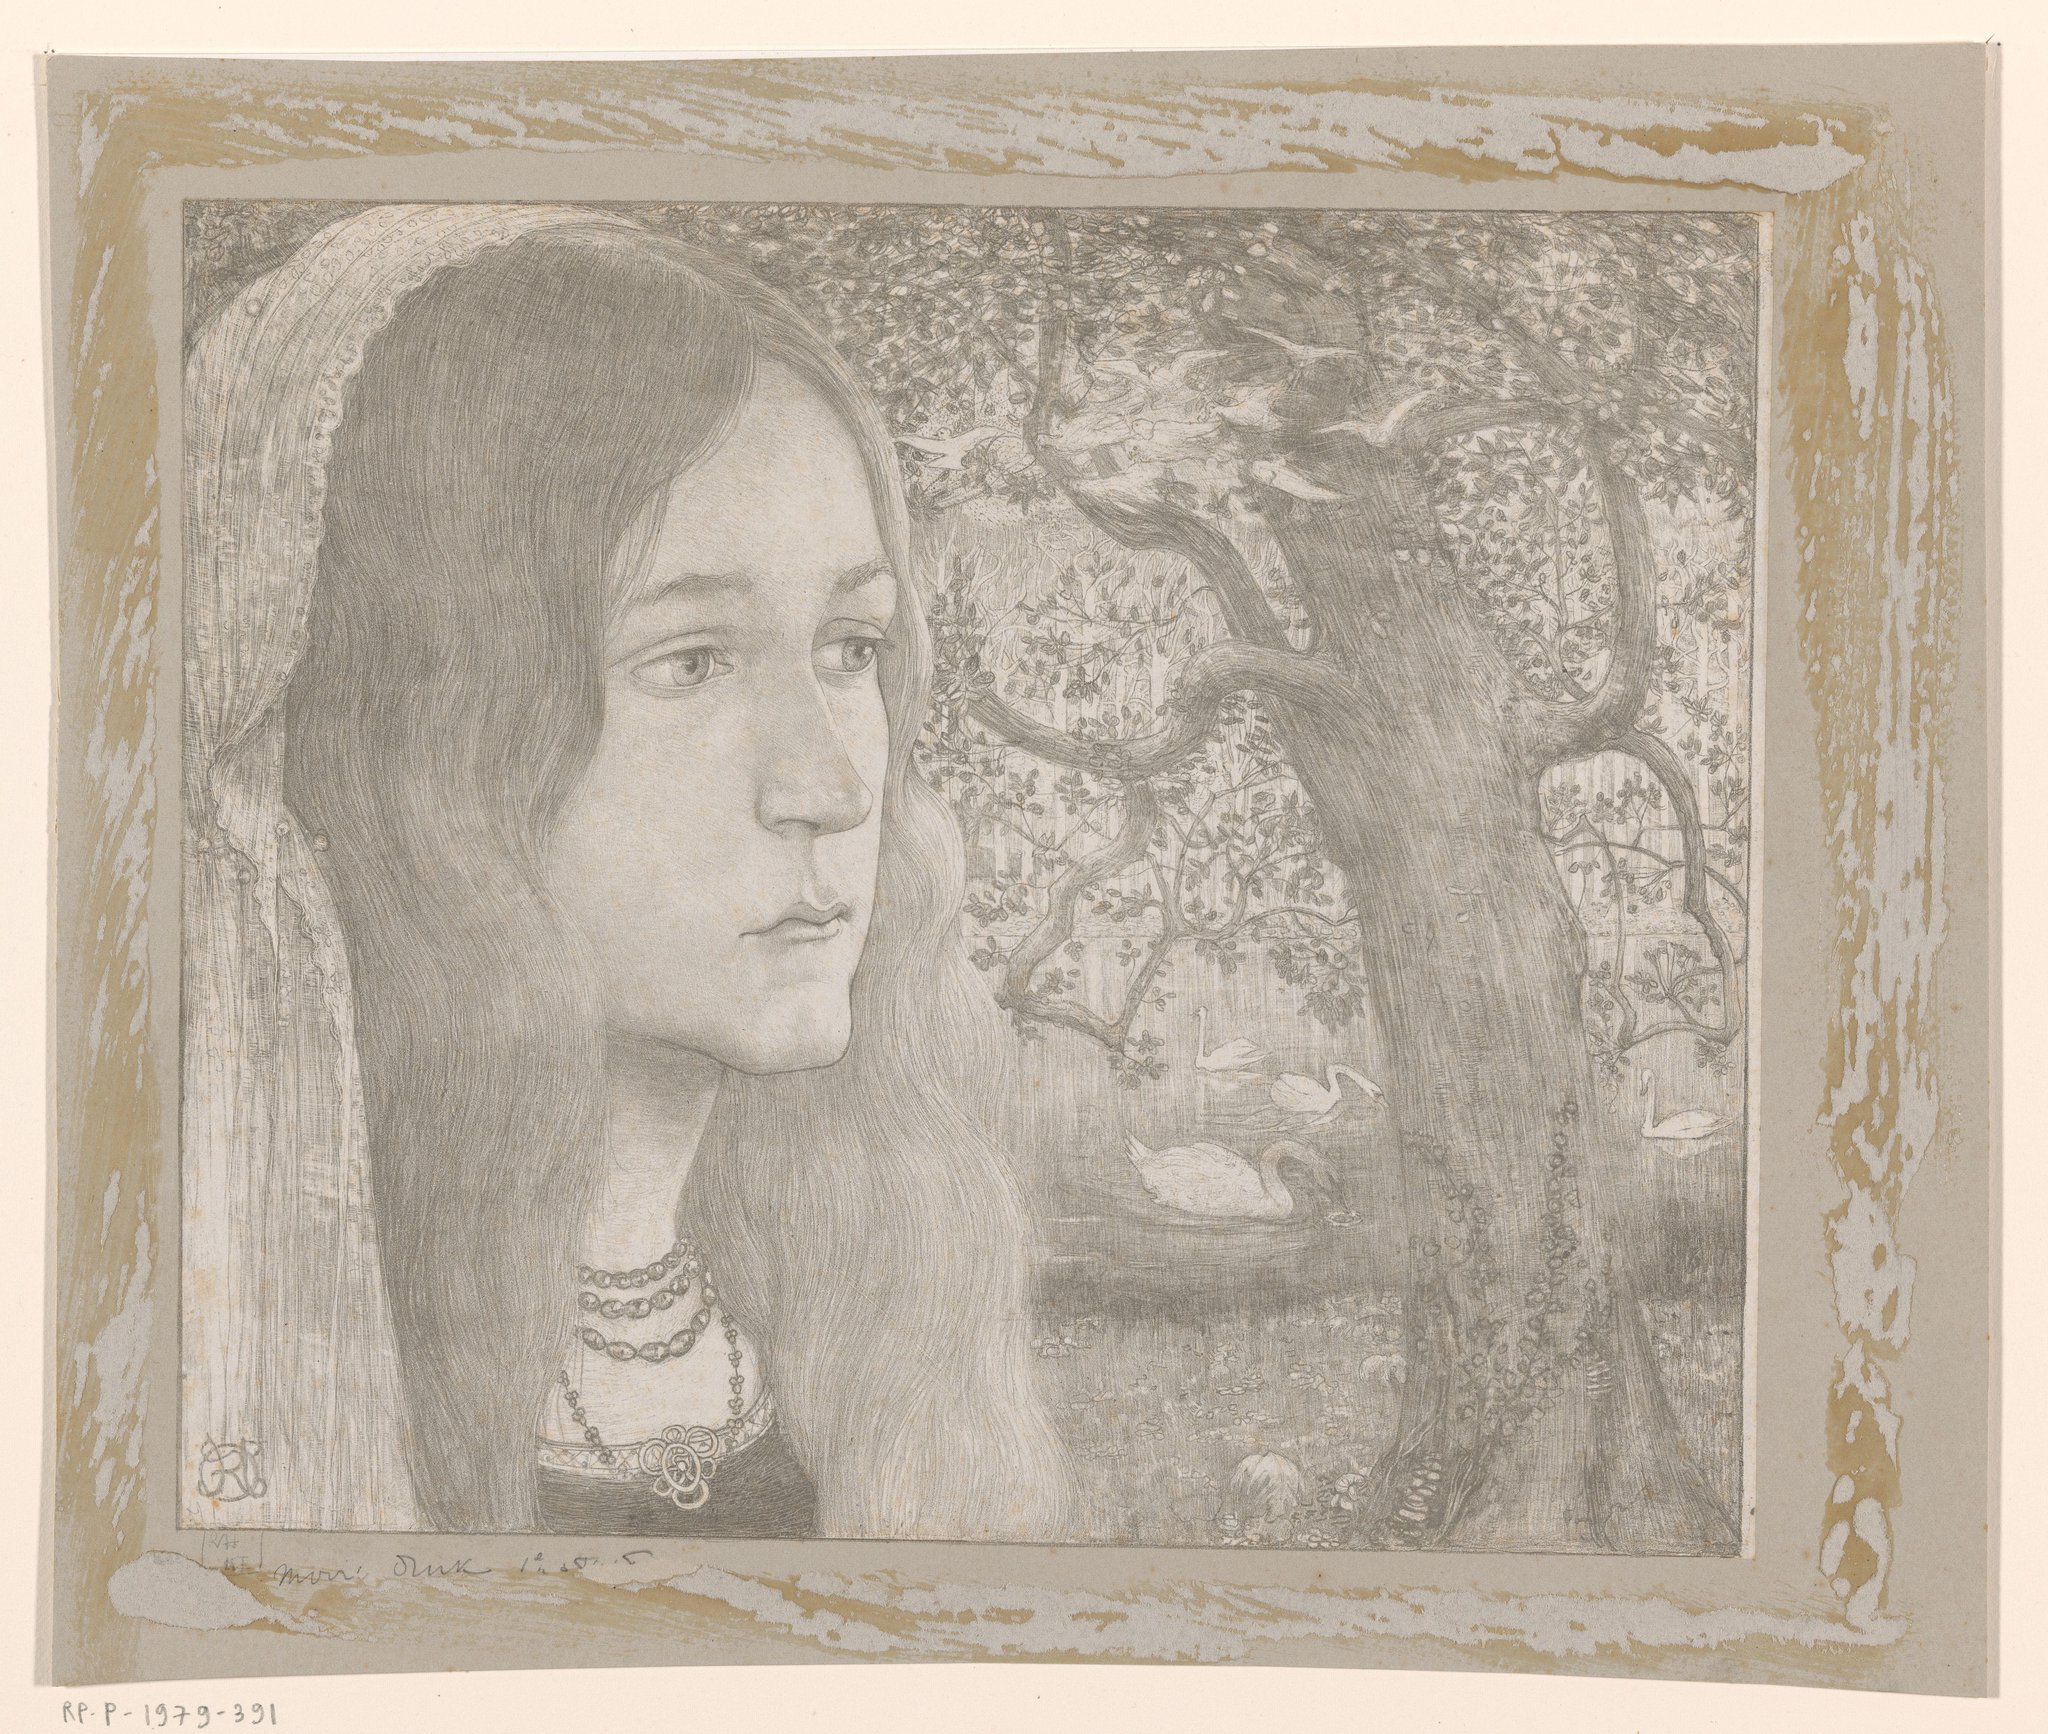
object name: print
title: Helga die voor zich uit kijkt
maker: richard nicolaüs roland holst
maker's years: 1868-1938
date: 1893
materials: paper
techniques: lithograph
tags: adolescent, young woman, maiden, trees, water-birds: swan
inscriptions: collector's mark: Lugt 2228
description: Prent geïnspireerd op de IJslandse saga van Gunnlaug Slangentong. In de saga dingen zowel Gunnlaug Slangentong en Raven de Skald om de hand van Helga. Beide mannen vinden uiteindelijk de dood.